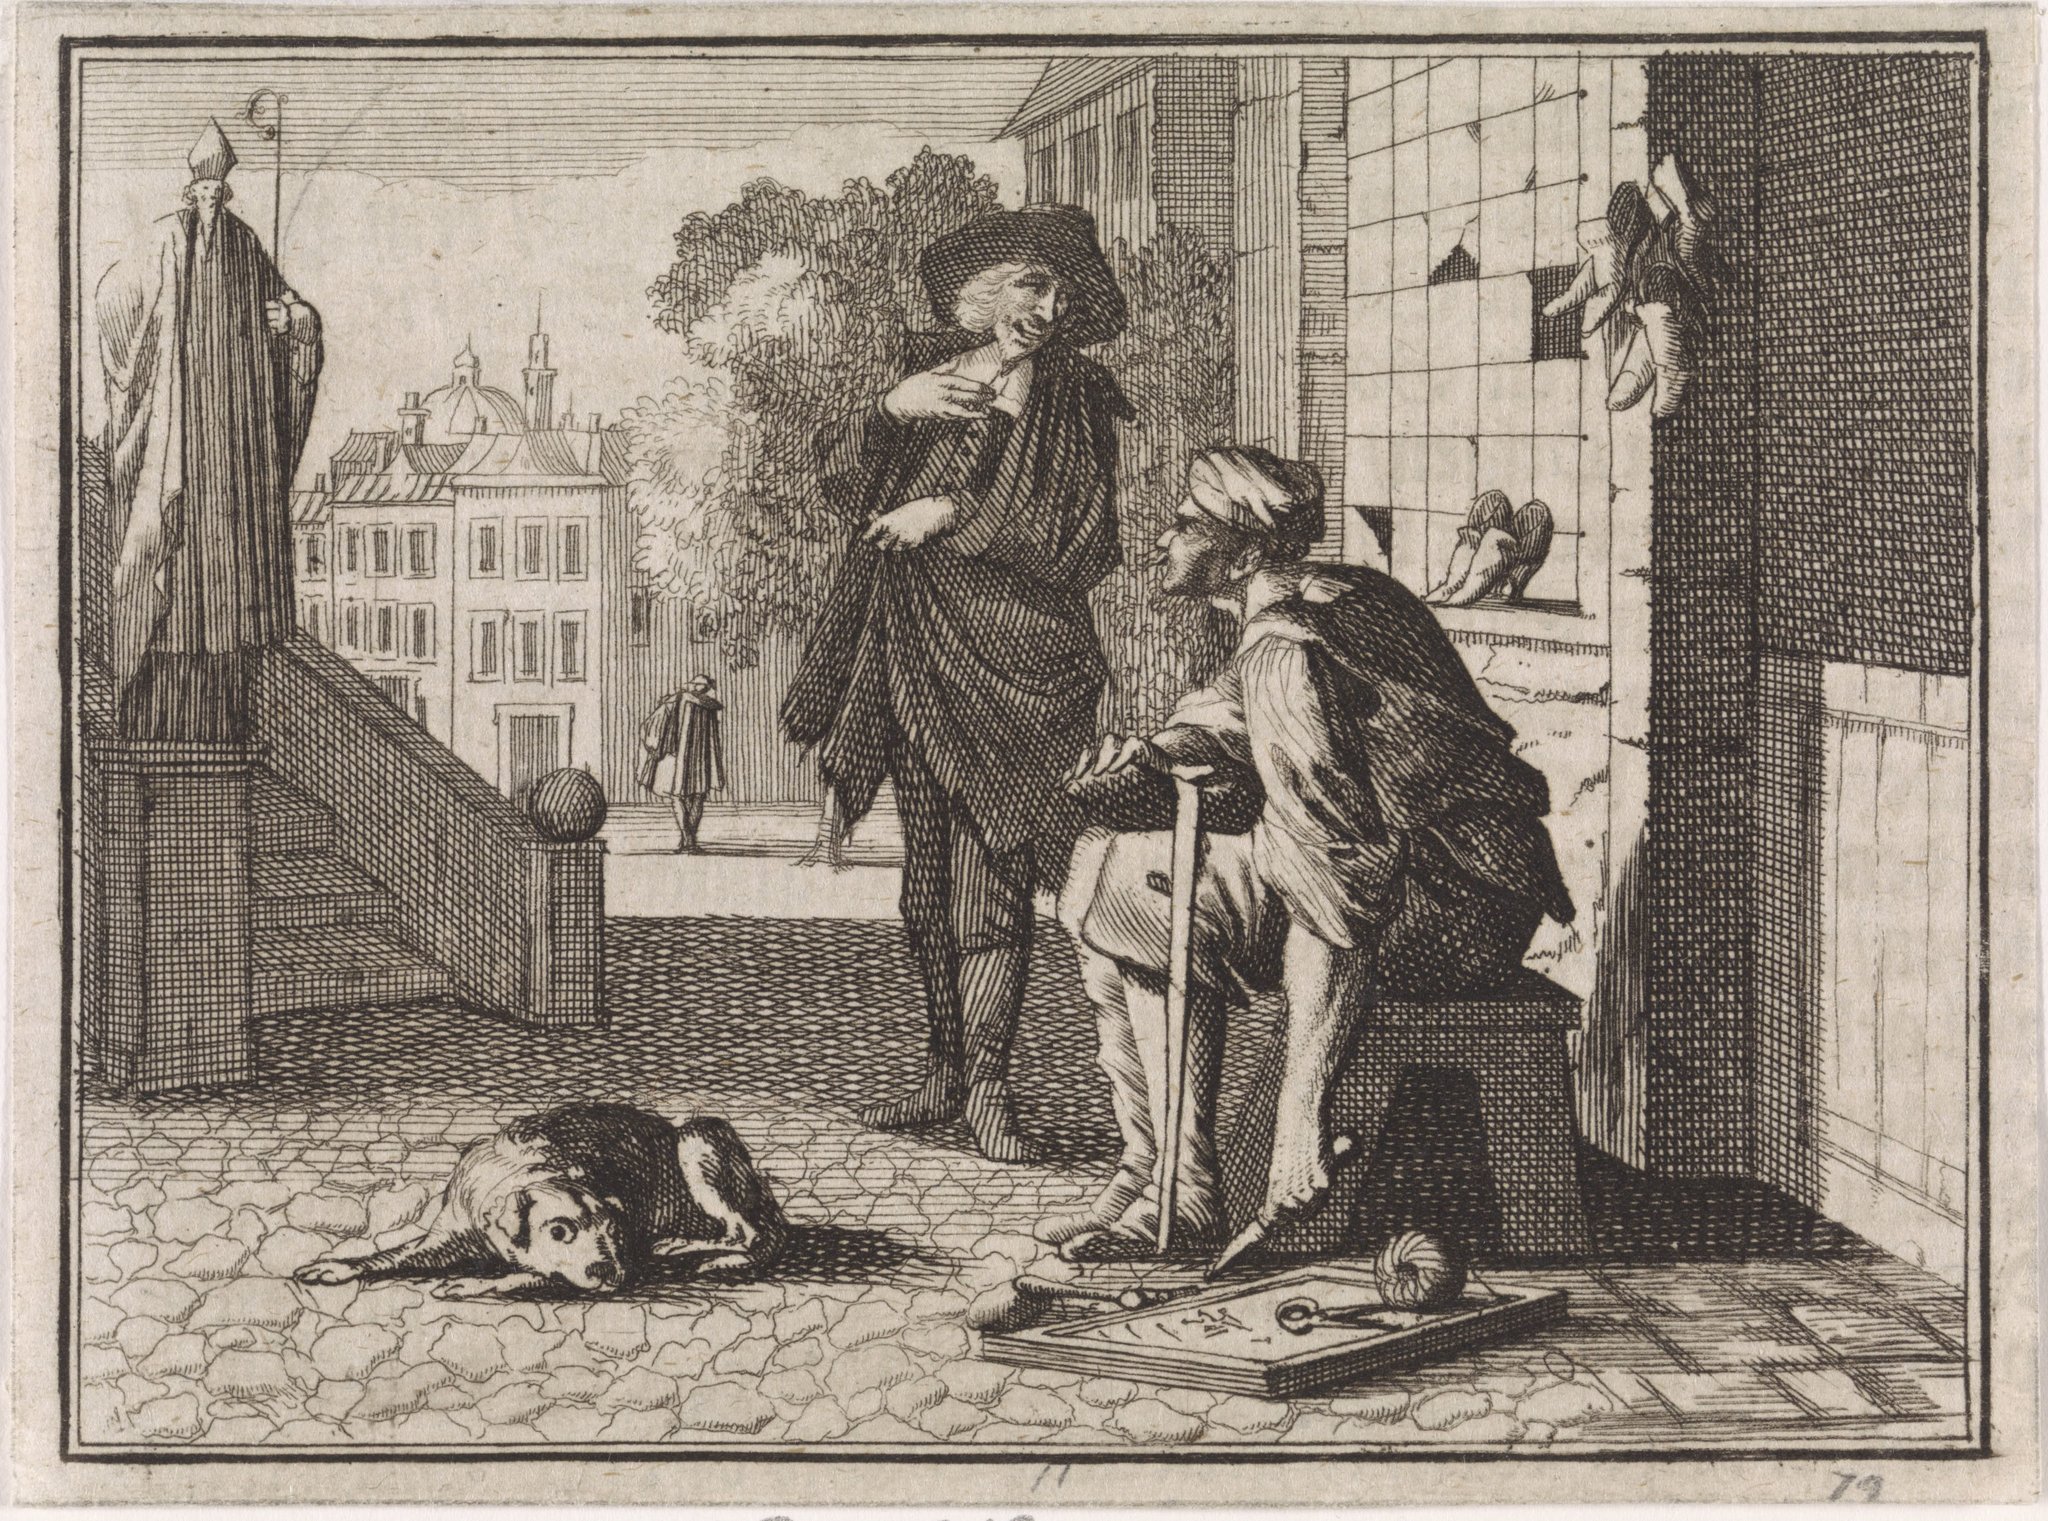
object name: book illustration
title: Arme schoenmaker in gesprek met een rijke man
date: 1704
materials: paper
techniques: etching, letterpress printing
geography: nuremberg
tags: contrast between rich and poor, conversation, dialogue; conversation piece, shoe-maker, cobbler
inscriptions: collector's mark: Lugt 2228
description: Illustratie uit: Abraham a Sancta Clara. Heilsames Gemisch Gemasch, das ist: Allerley seltsame und verwunderliche Geschichten (...). Neurenberg: Christoph Weigel, 1704, p. 79.